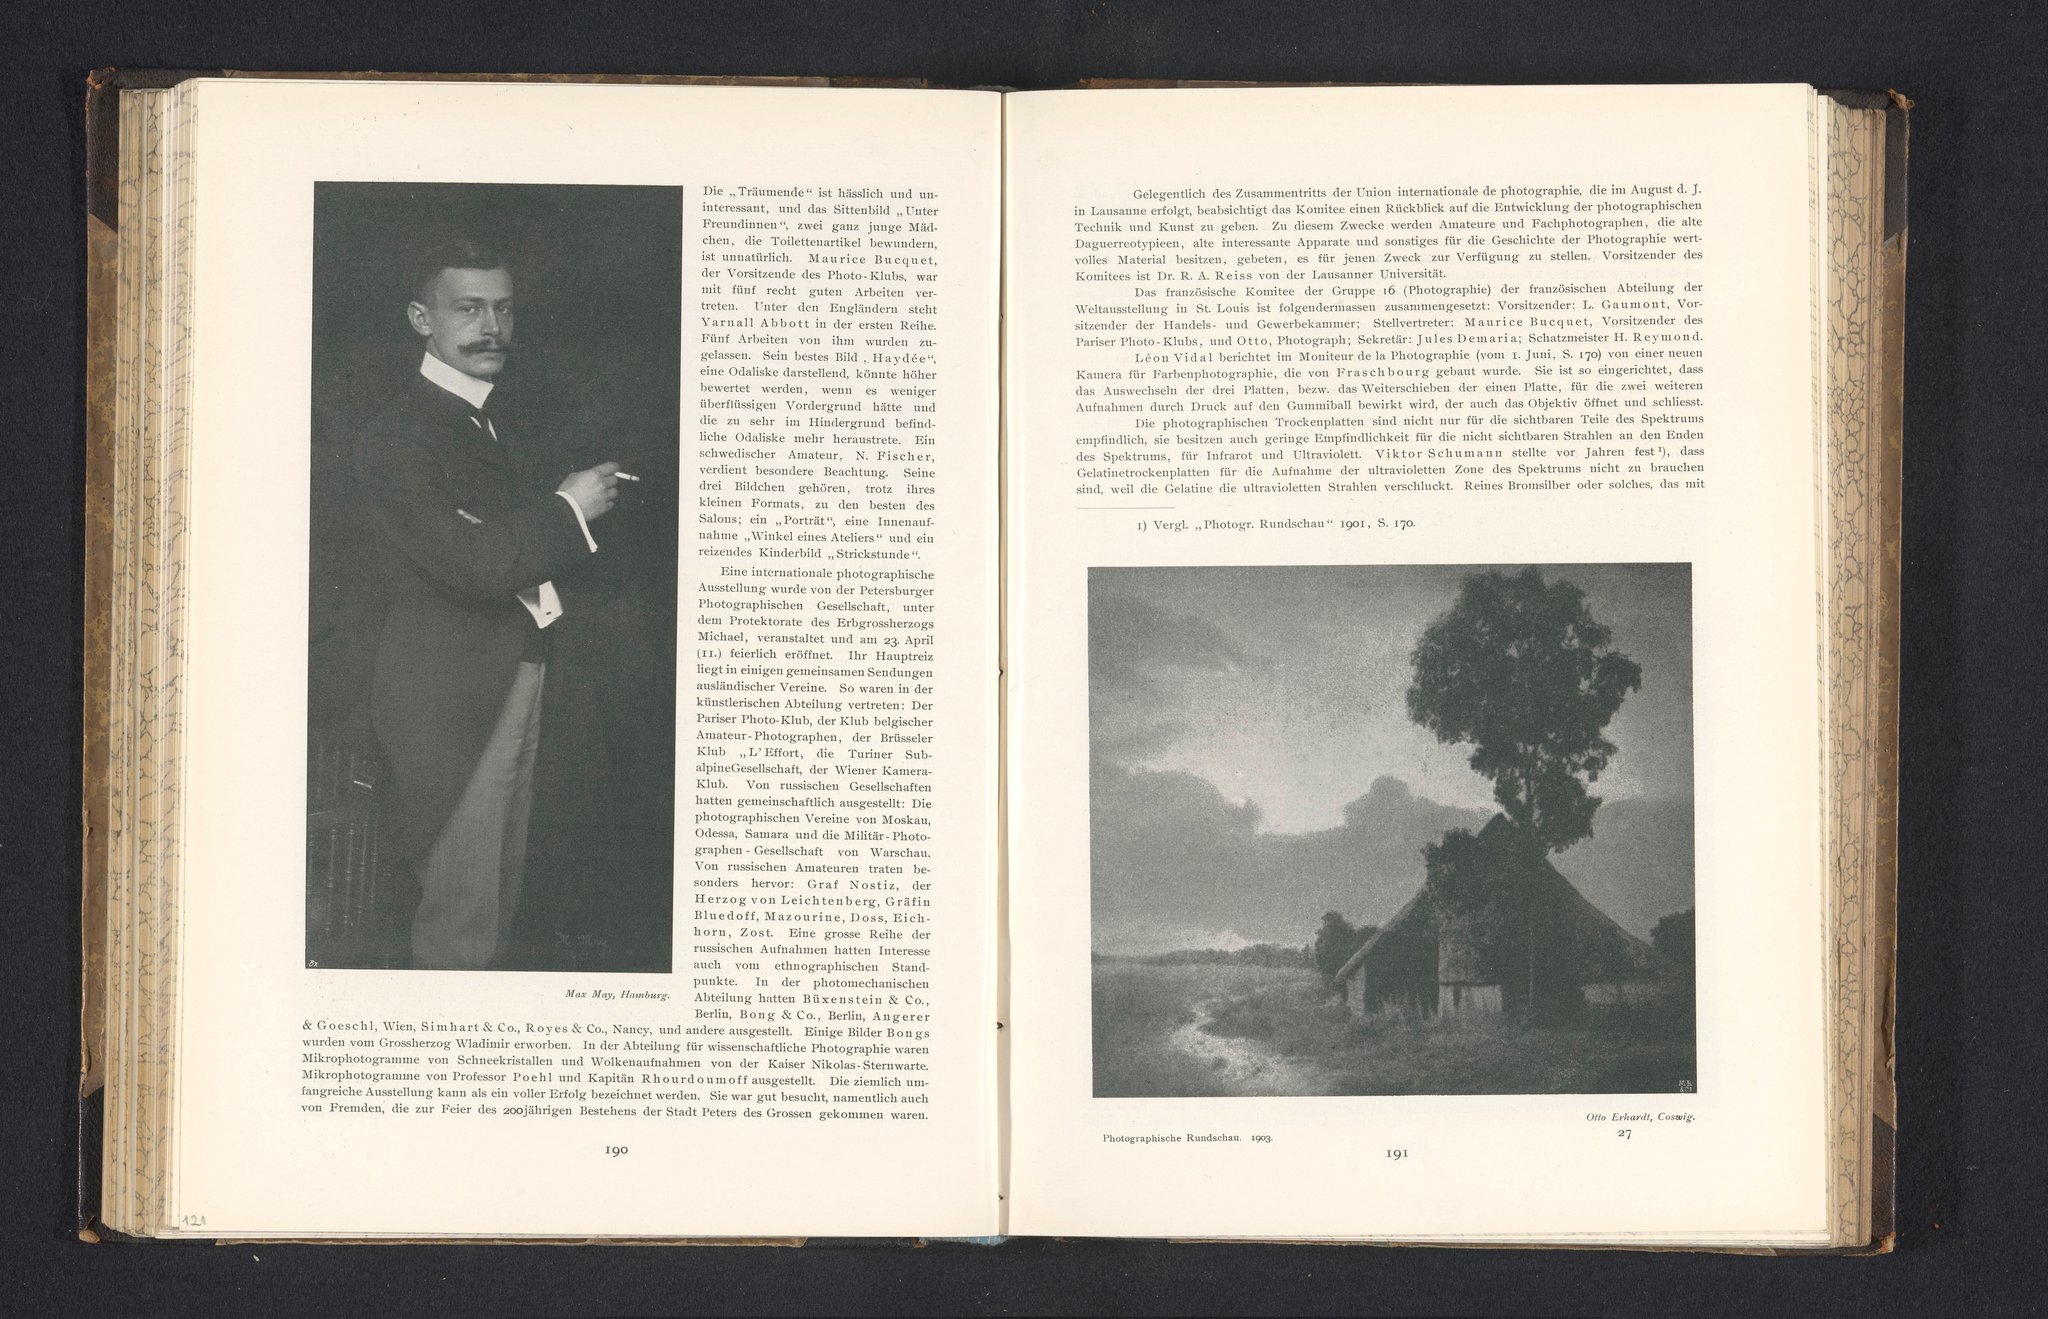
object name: page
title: Portret van een onbekende man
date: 1898-1903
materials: paper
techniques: autotype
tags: historical persons not known by name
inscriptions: monogram: ‘BX’